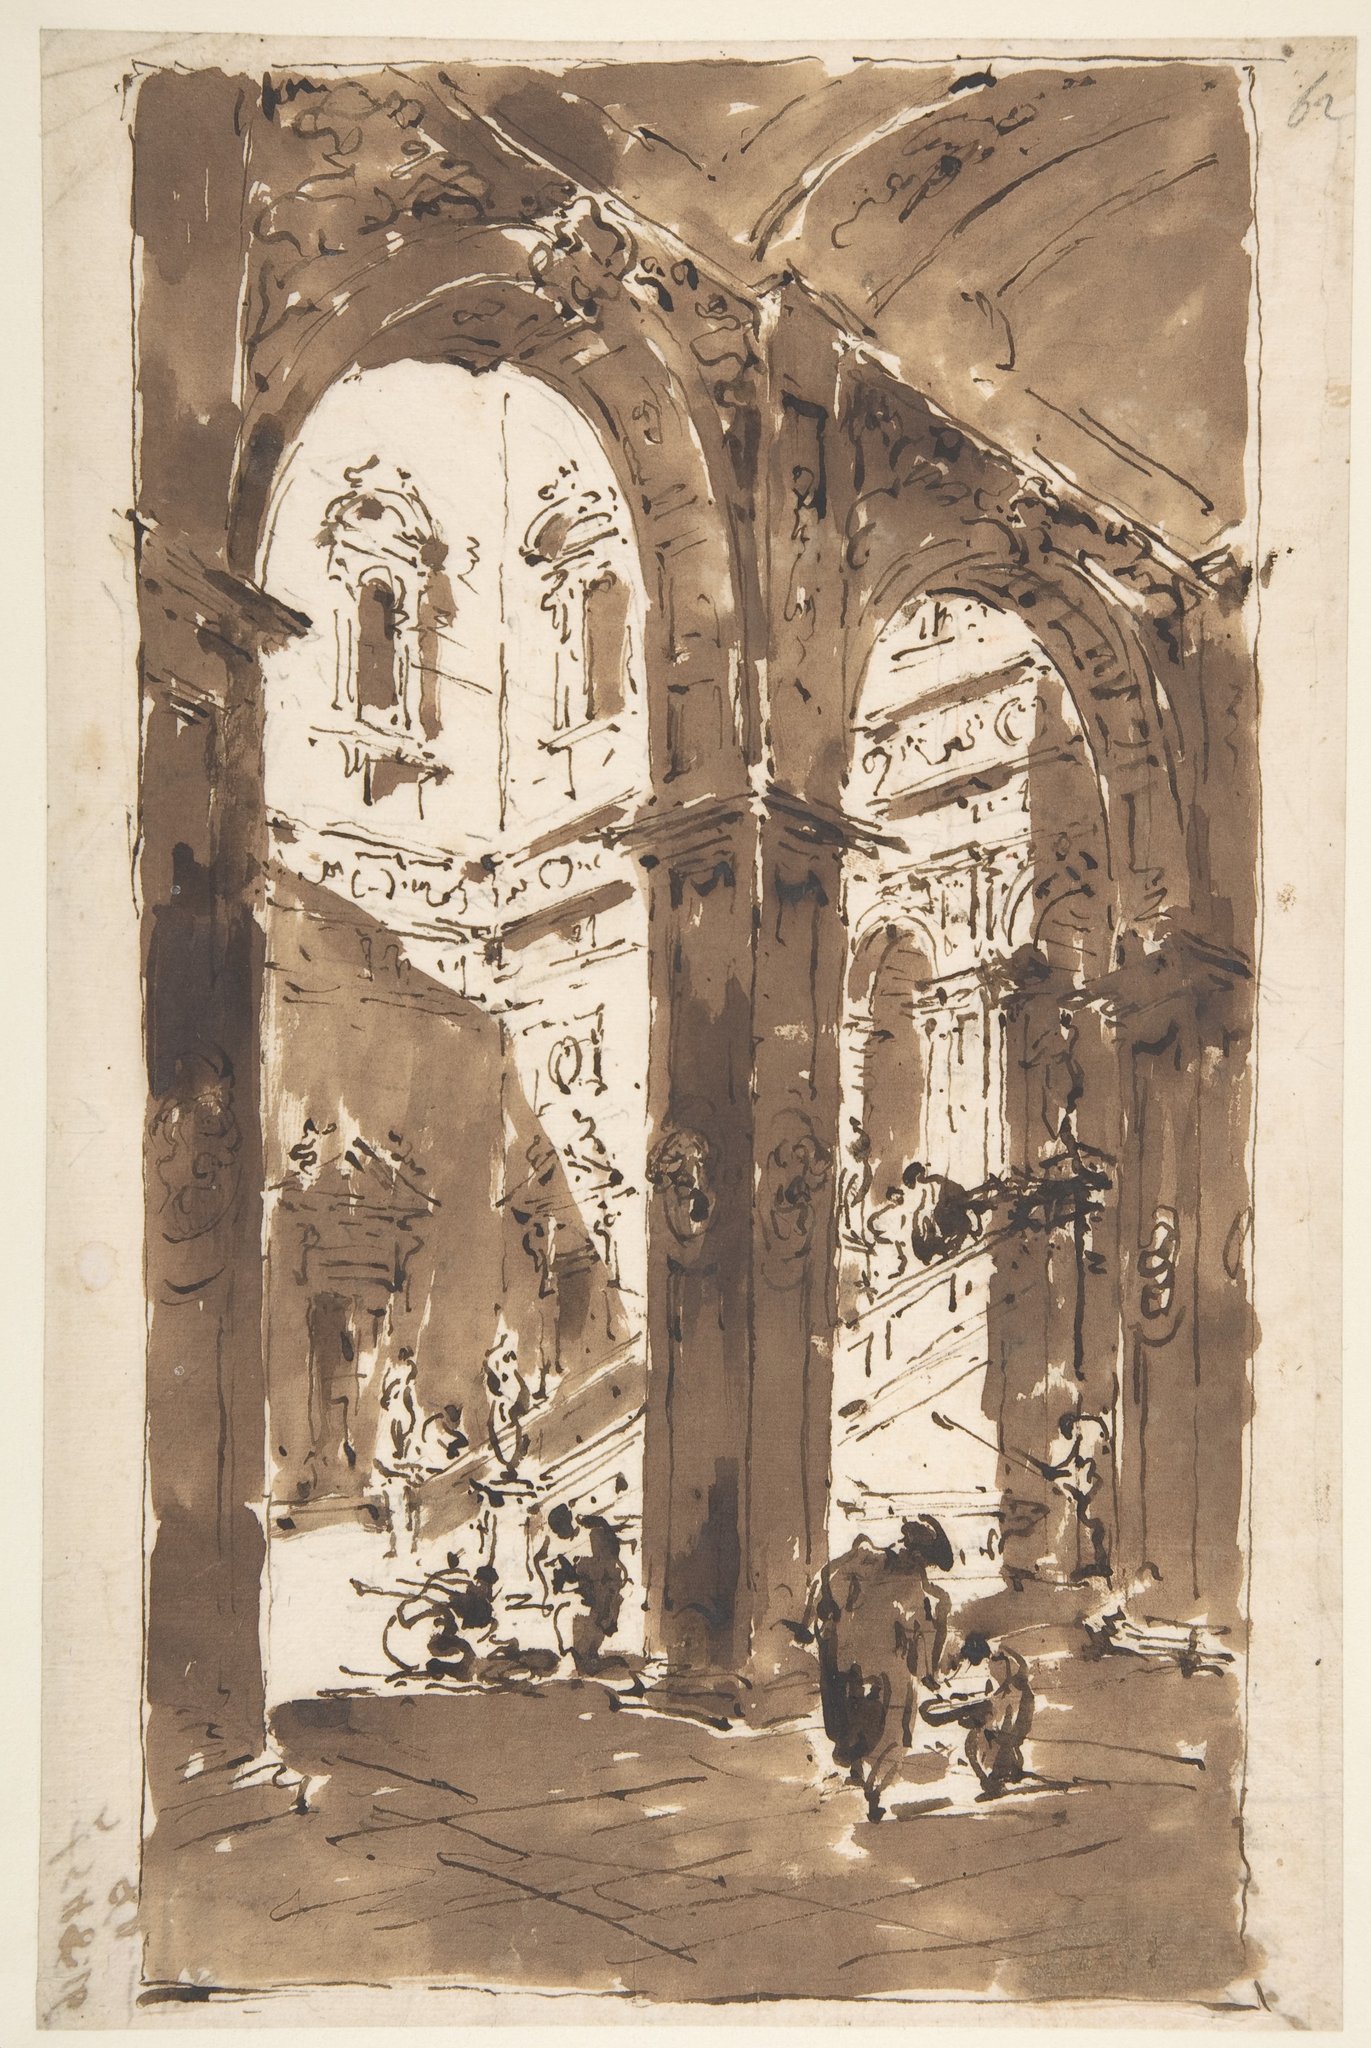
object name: drawing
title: Architectural Capriccio: Courtyard of a Palace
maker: francesco guardi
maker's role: artist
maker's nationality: italian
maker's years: 1712-1793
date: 1712-1793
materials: chalk, graphite, ink, lead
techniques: brush, pen, wash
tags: architecture,courtyards